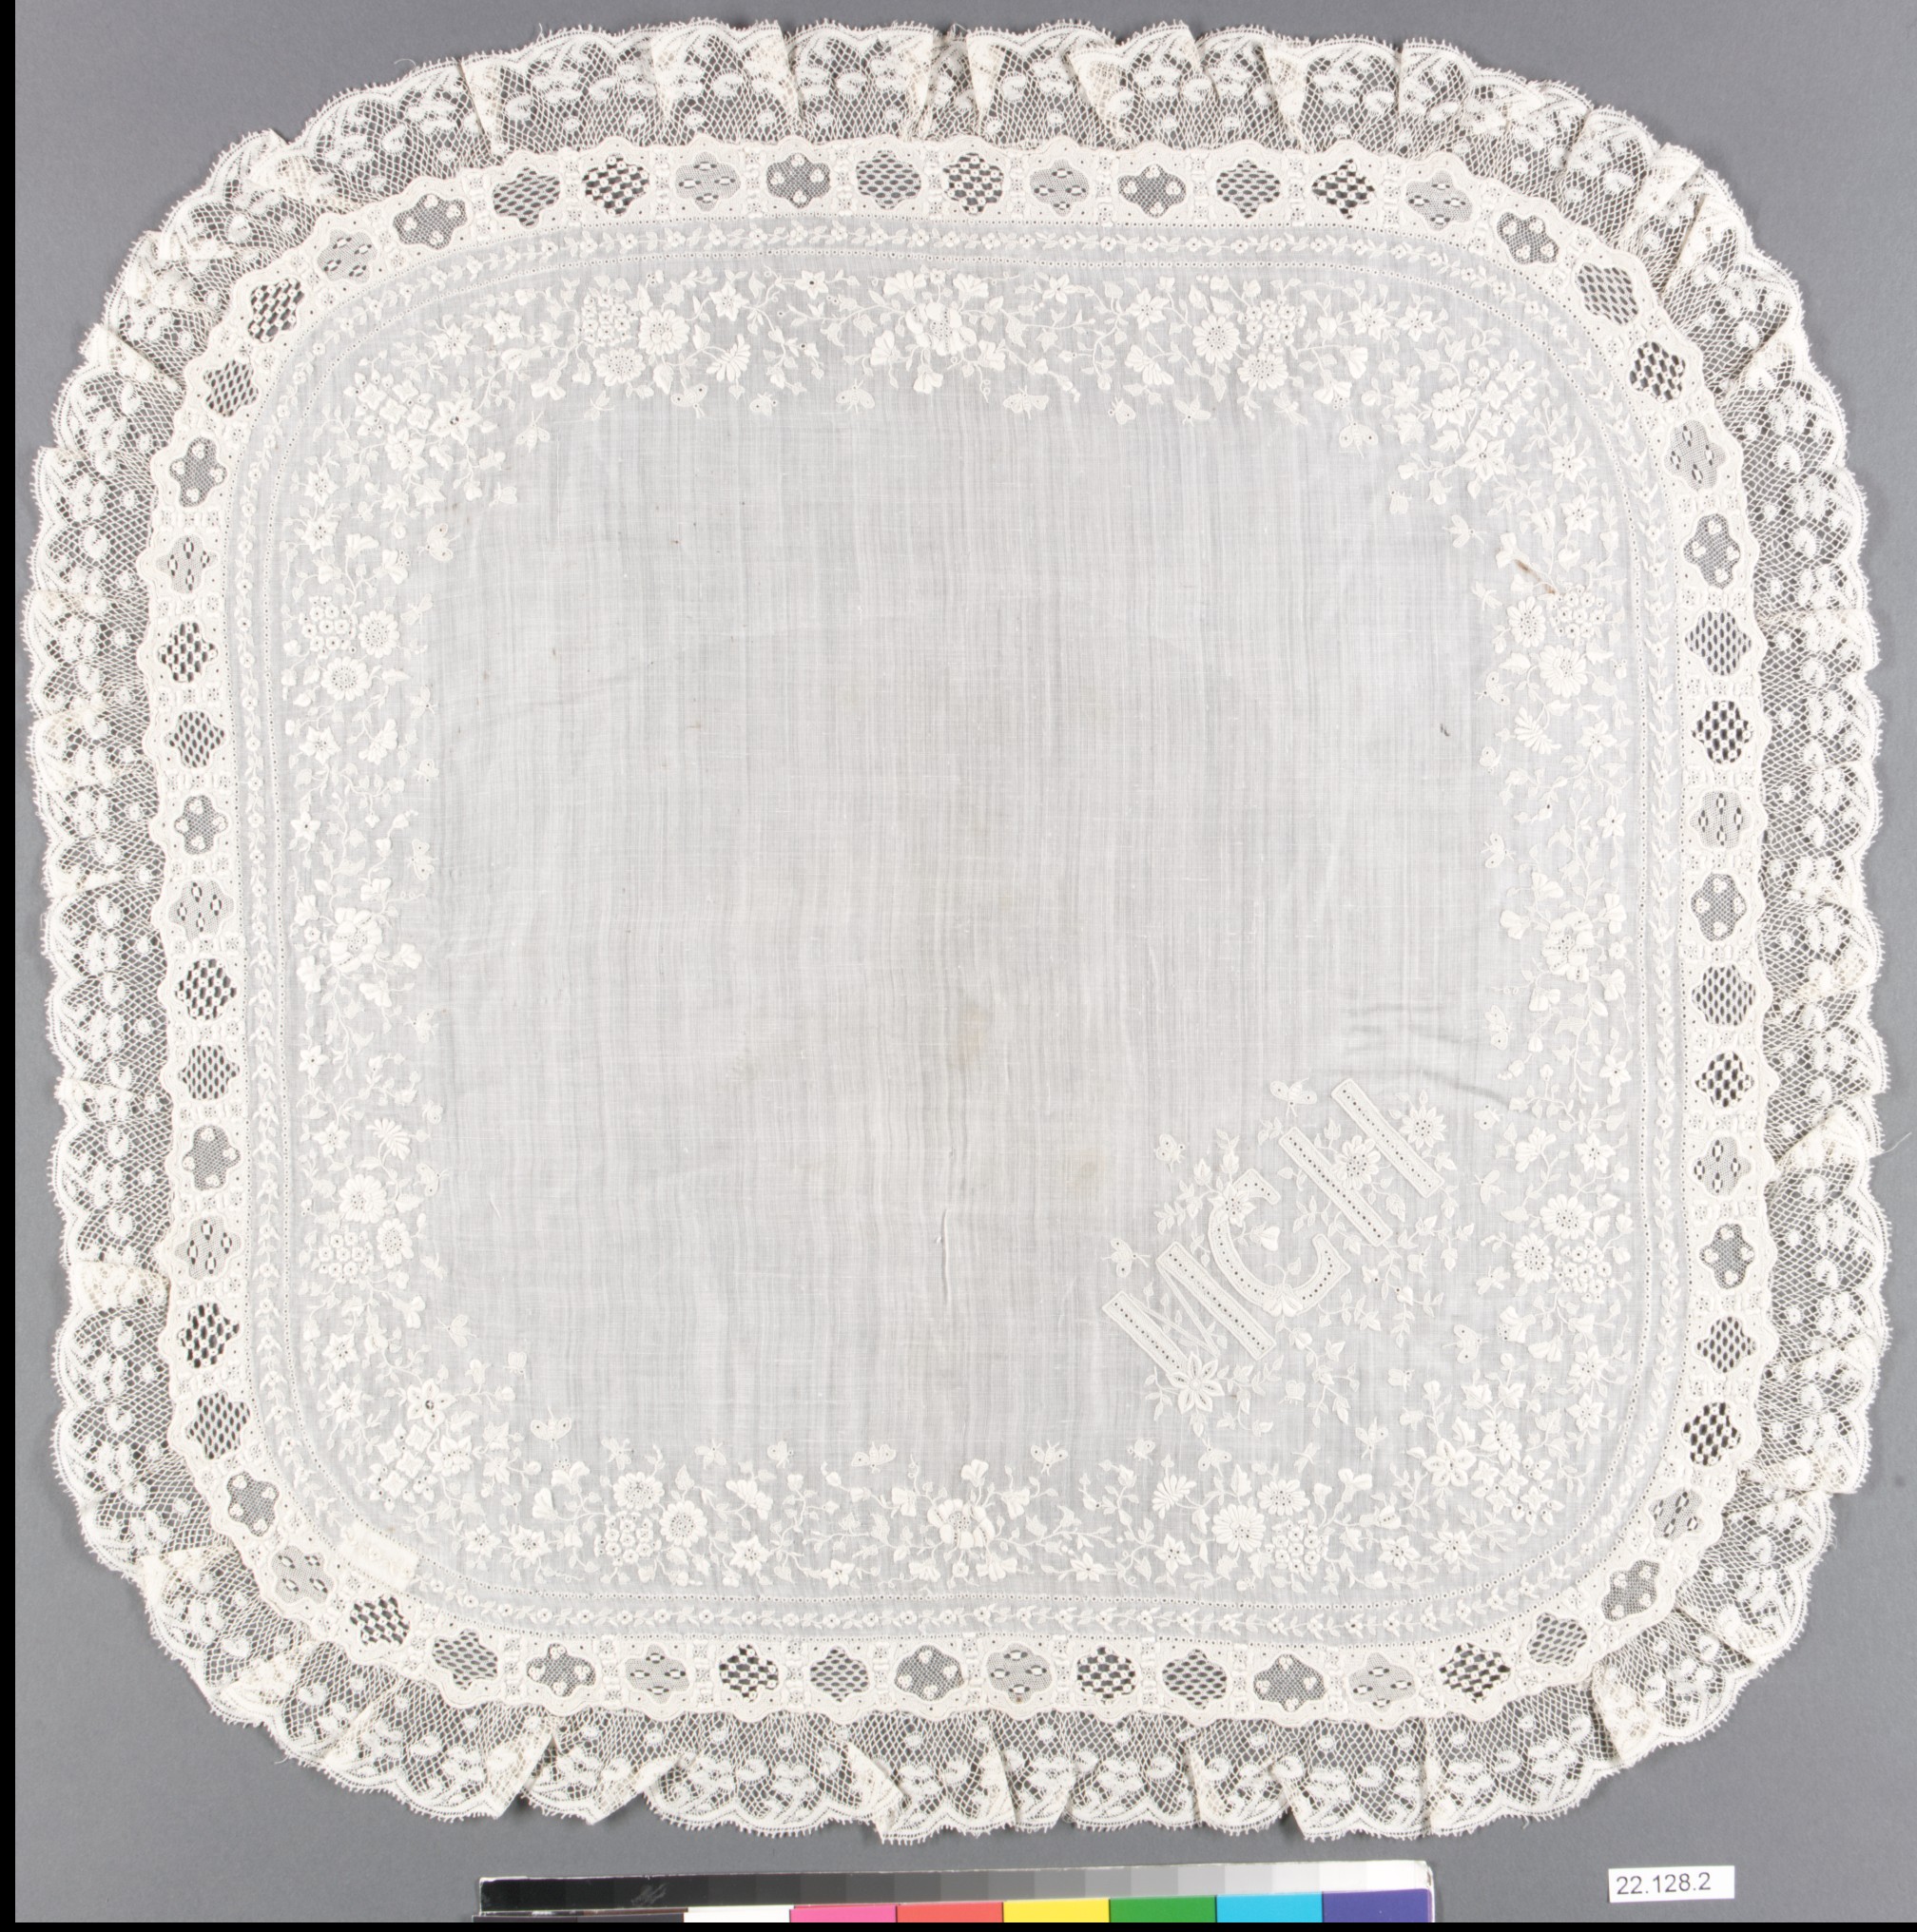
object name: handkerchief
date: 1863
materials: linen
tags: flowers